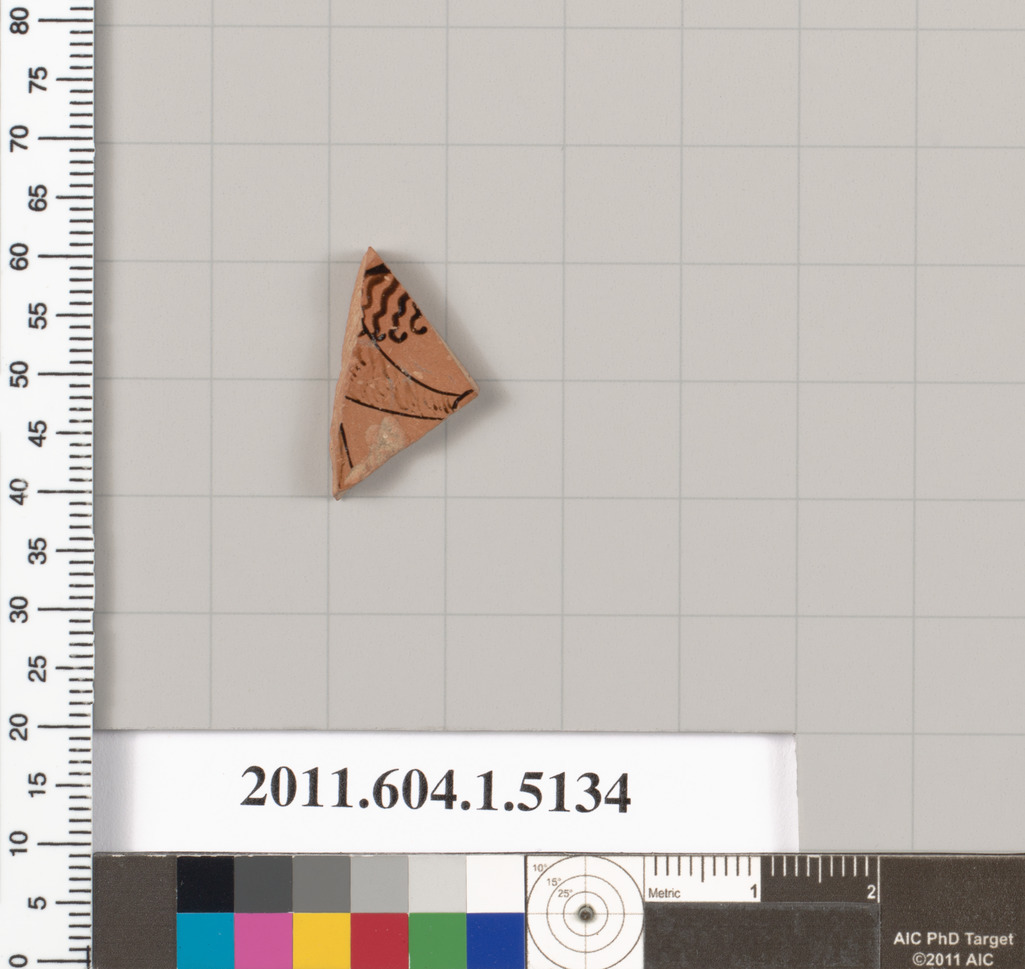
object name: kylix fragment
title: Terracotta fragment of a kylix (drinking cup)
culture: greek, attic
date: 490-480 BCE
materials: terracotta